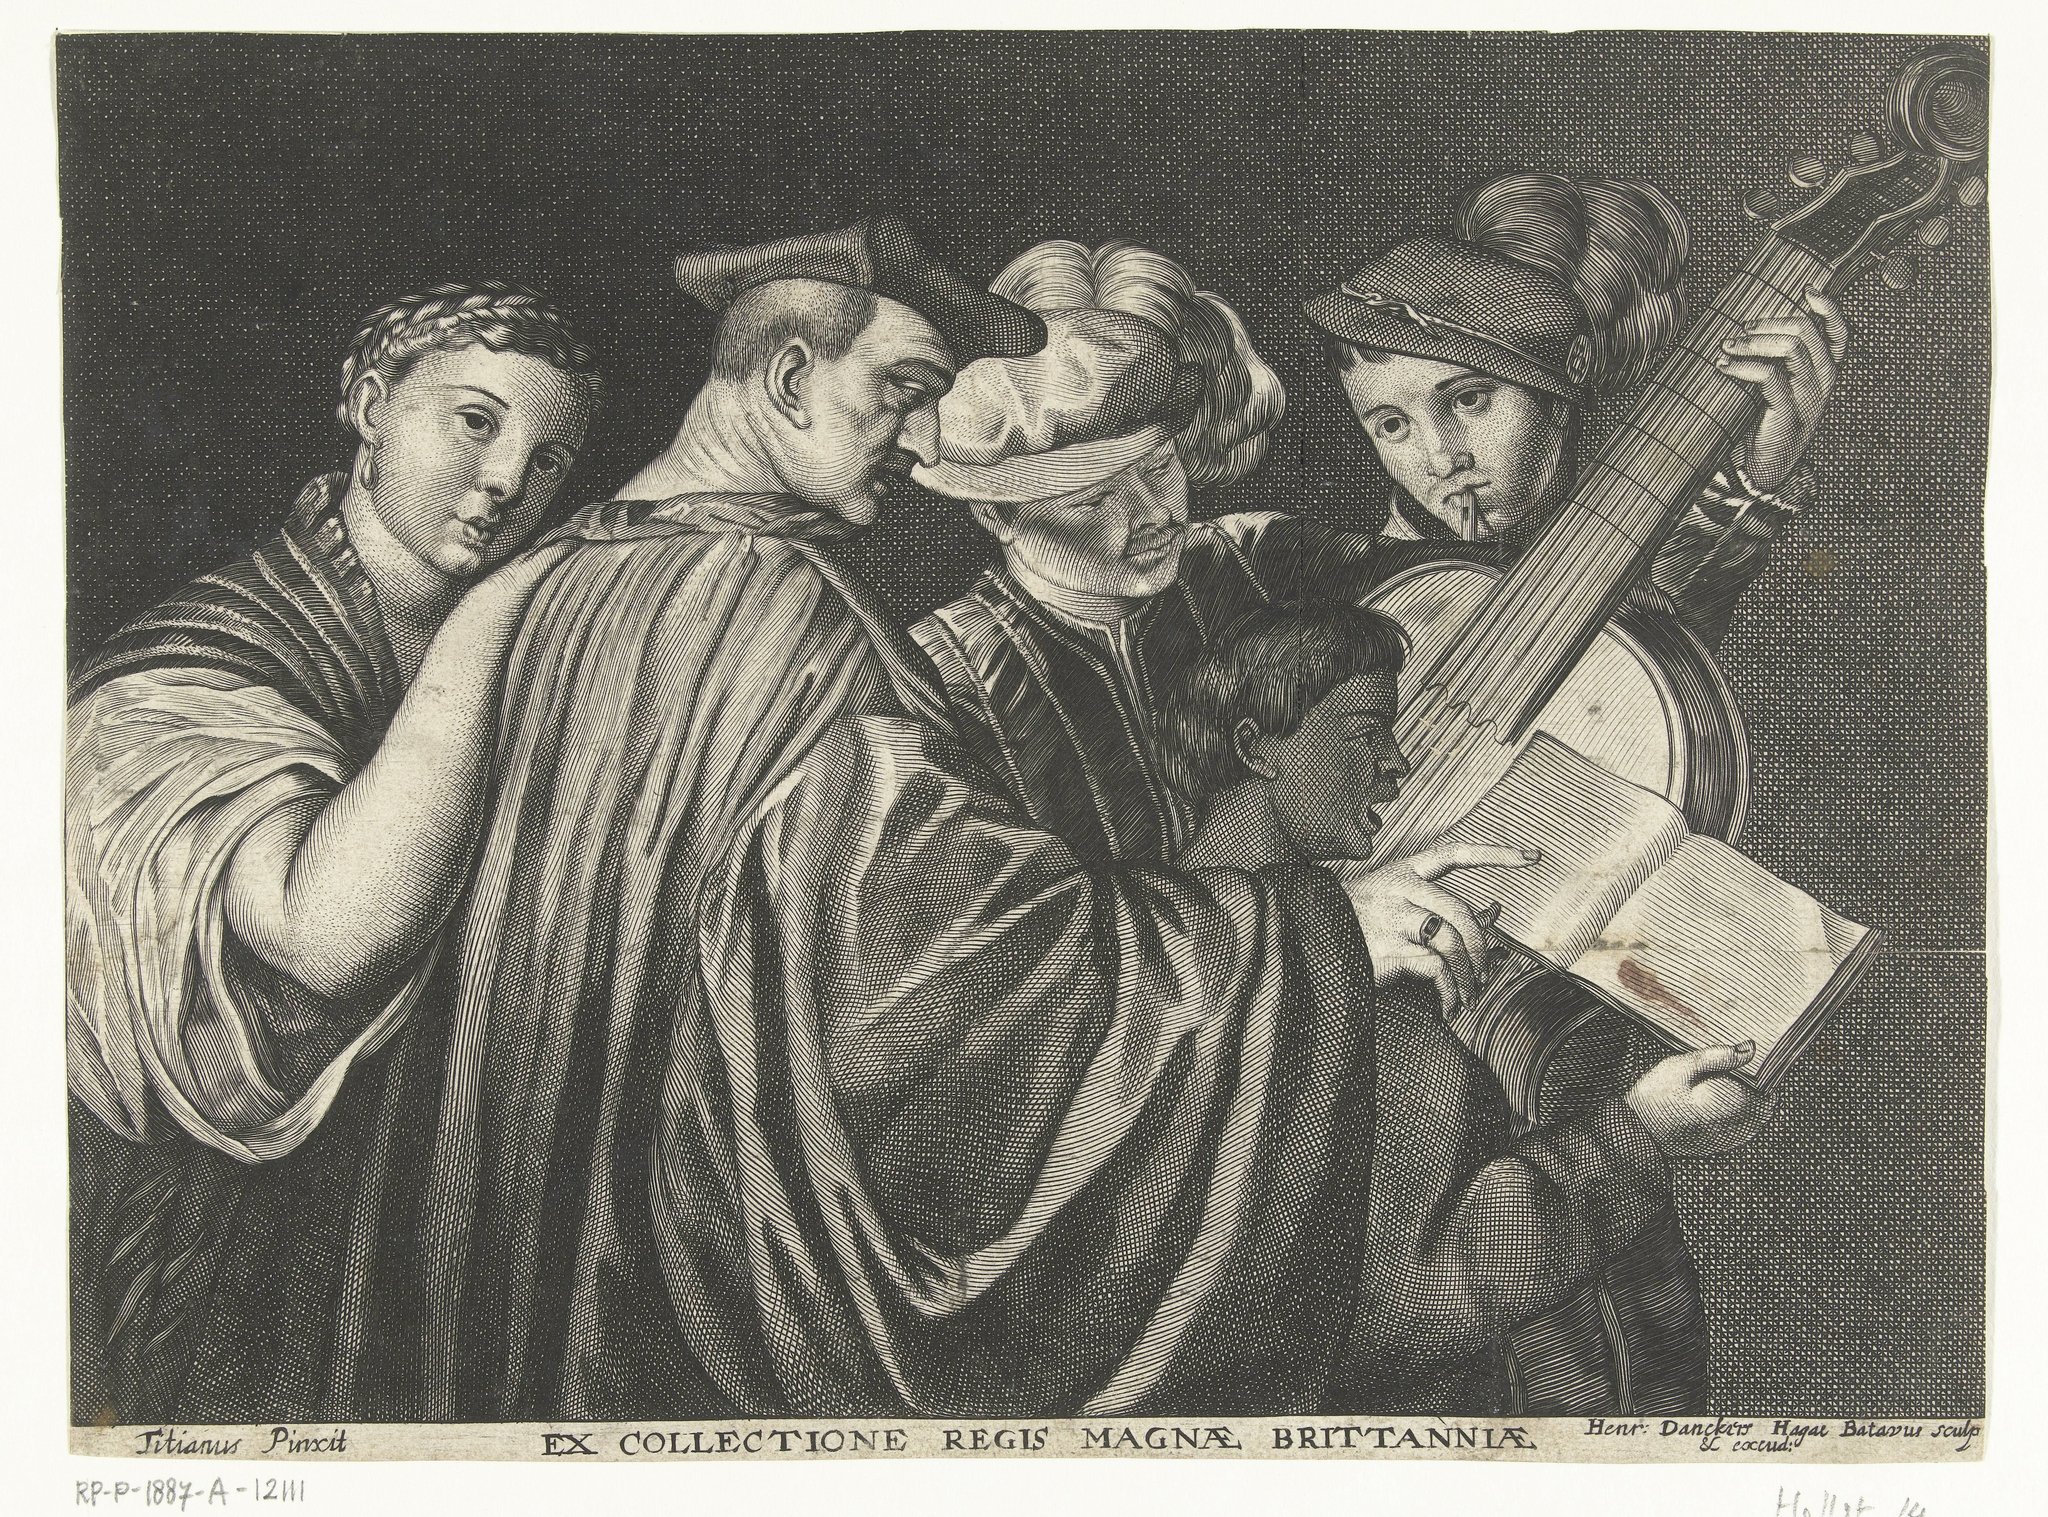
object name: print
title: Het concert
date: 1635-1679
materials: paper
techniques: engraving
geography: the hague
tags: instrumental and vocal music together, more than one musician with instrument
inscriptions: collector's mark: Lugt 2228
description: Prent naar schilderij van navolger van Titiaan in de collectie van de National Gallery te Londen.